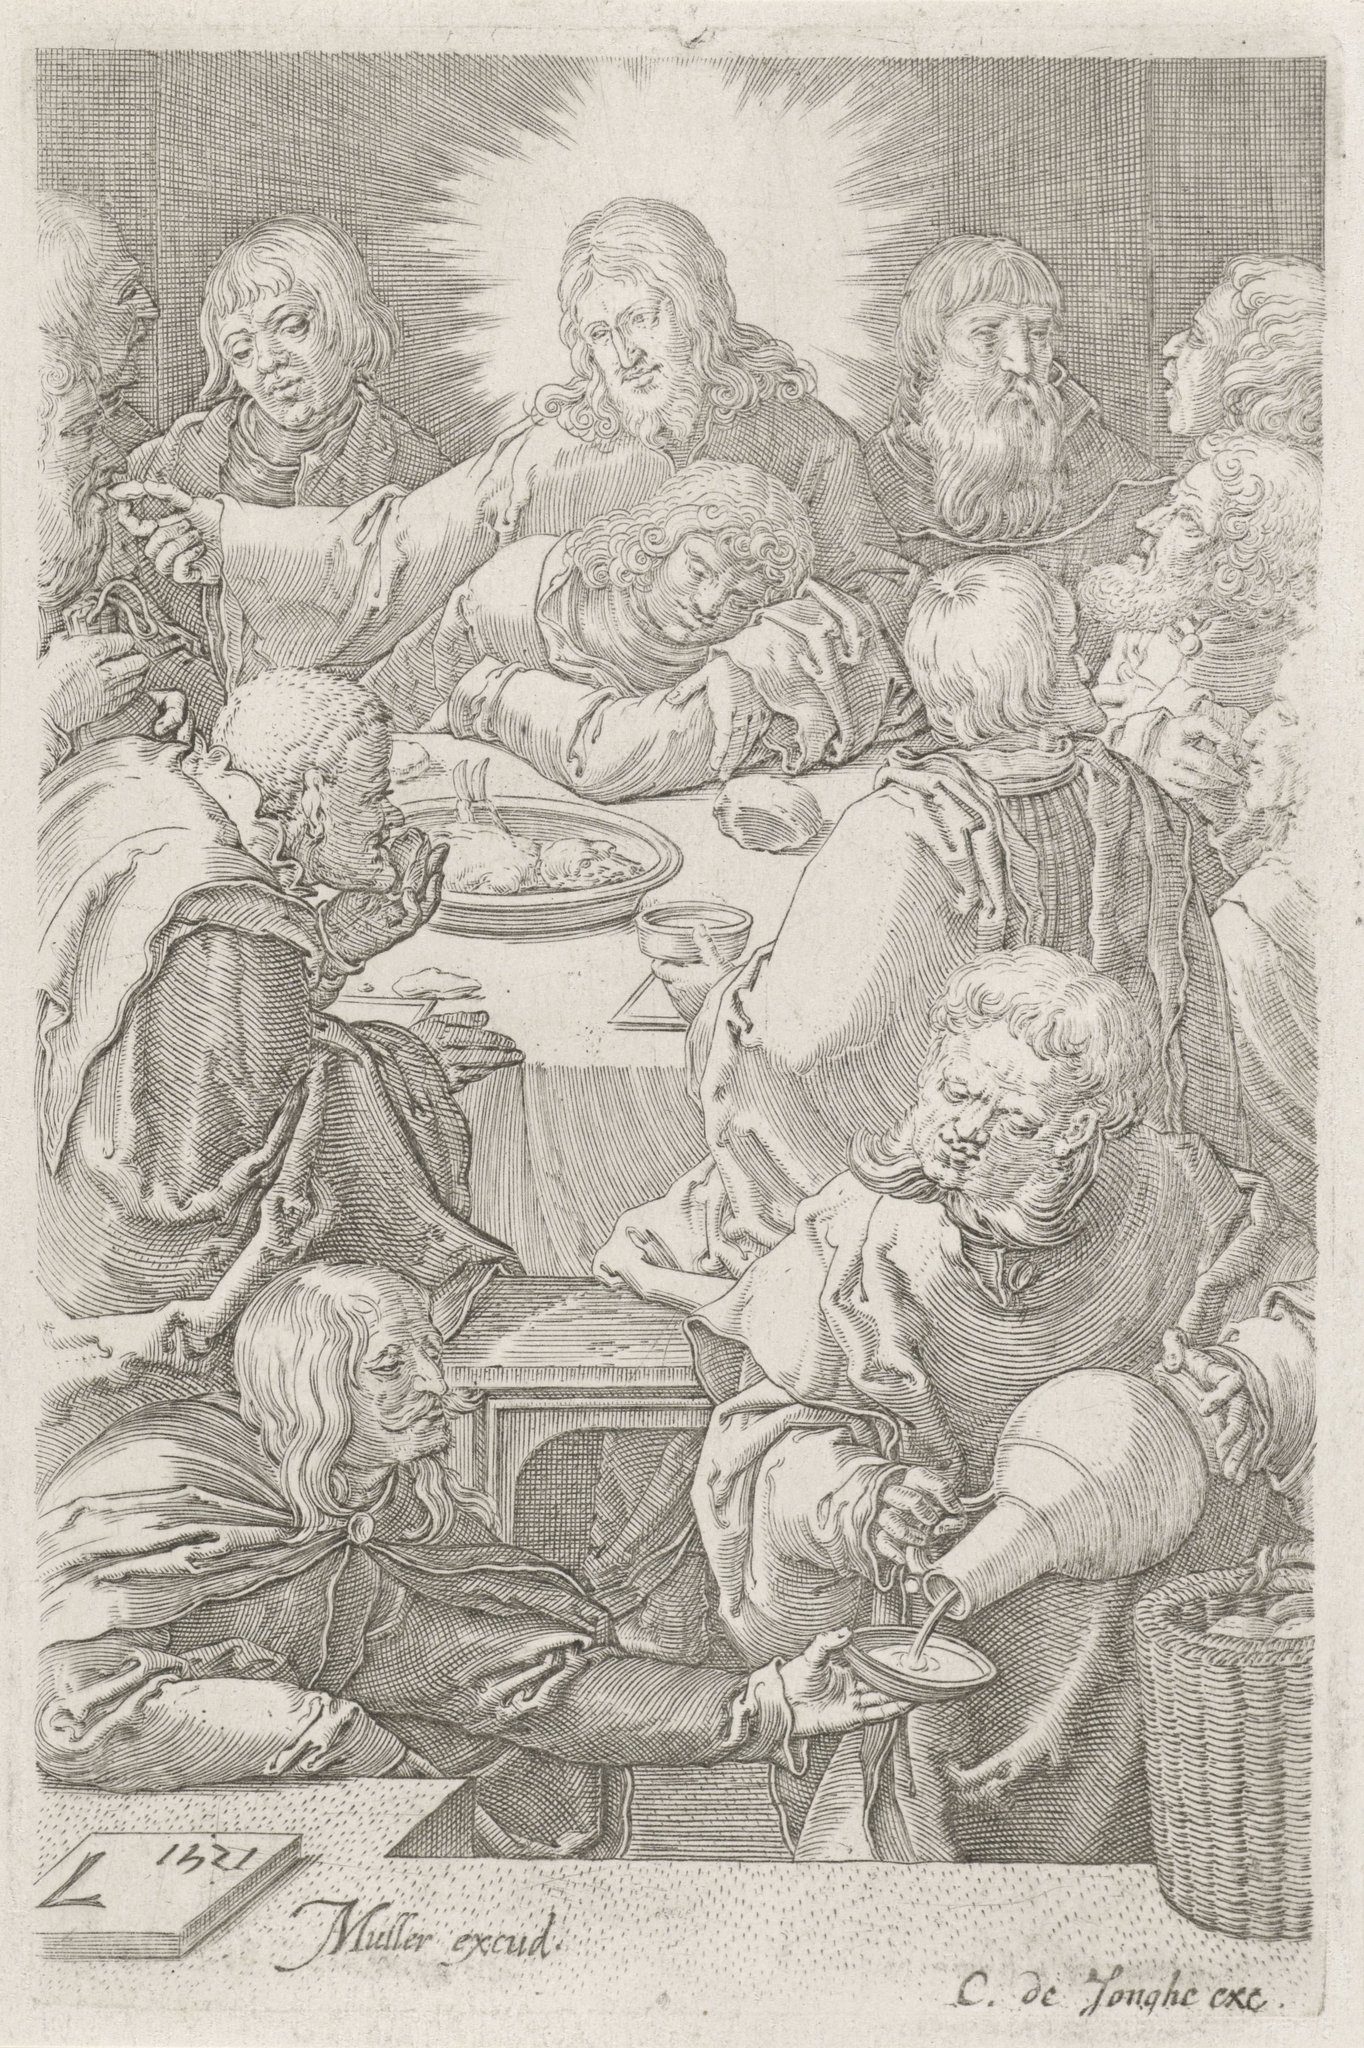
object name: print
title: Passie van Christus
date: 1613-1622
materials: paper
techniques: engraving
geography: amsterdam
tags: last supper (in general) (matthew 26:21-35; mark 14:18-31; luke 22:3, 22:15-23; john 13:21-38)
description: De serie is in de negentiende eeuw herdrukt met de titel: Die Leiden Christi. La Passion de Jesus-Christ. 14 Blatt. Nach Lucas von Leyden in Kupfer gestochen von J. Müller. Wellicht een reproductie?